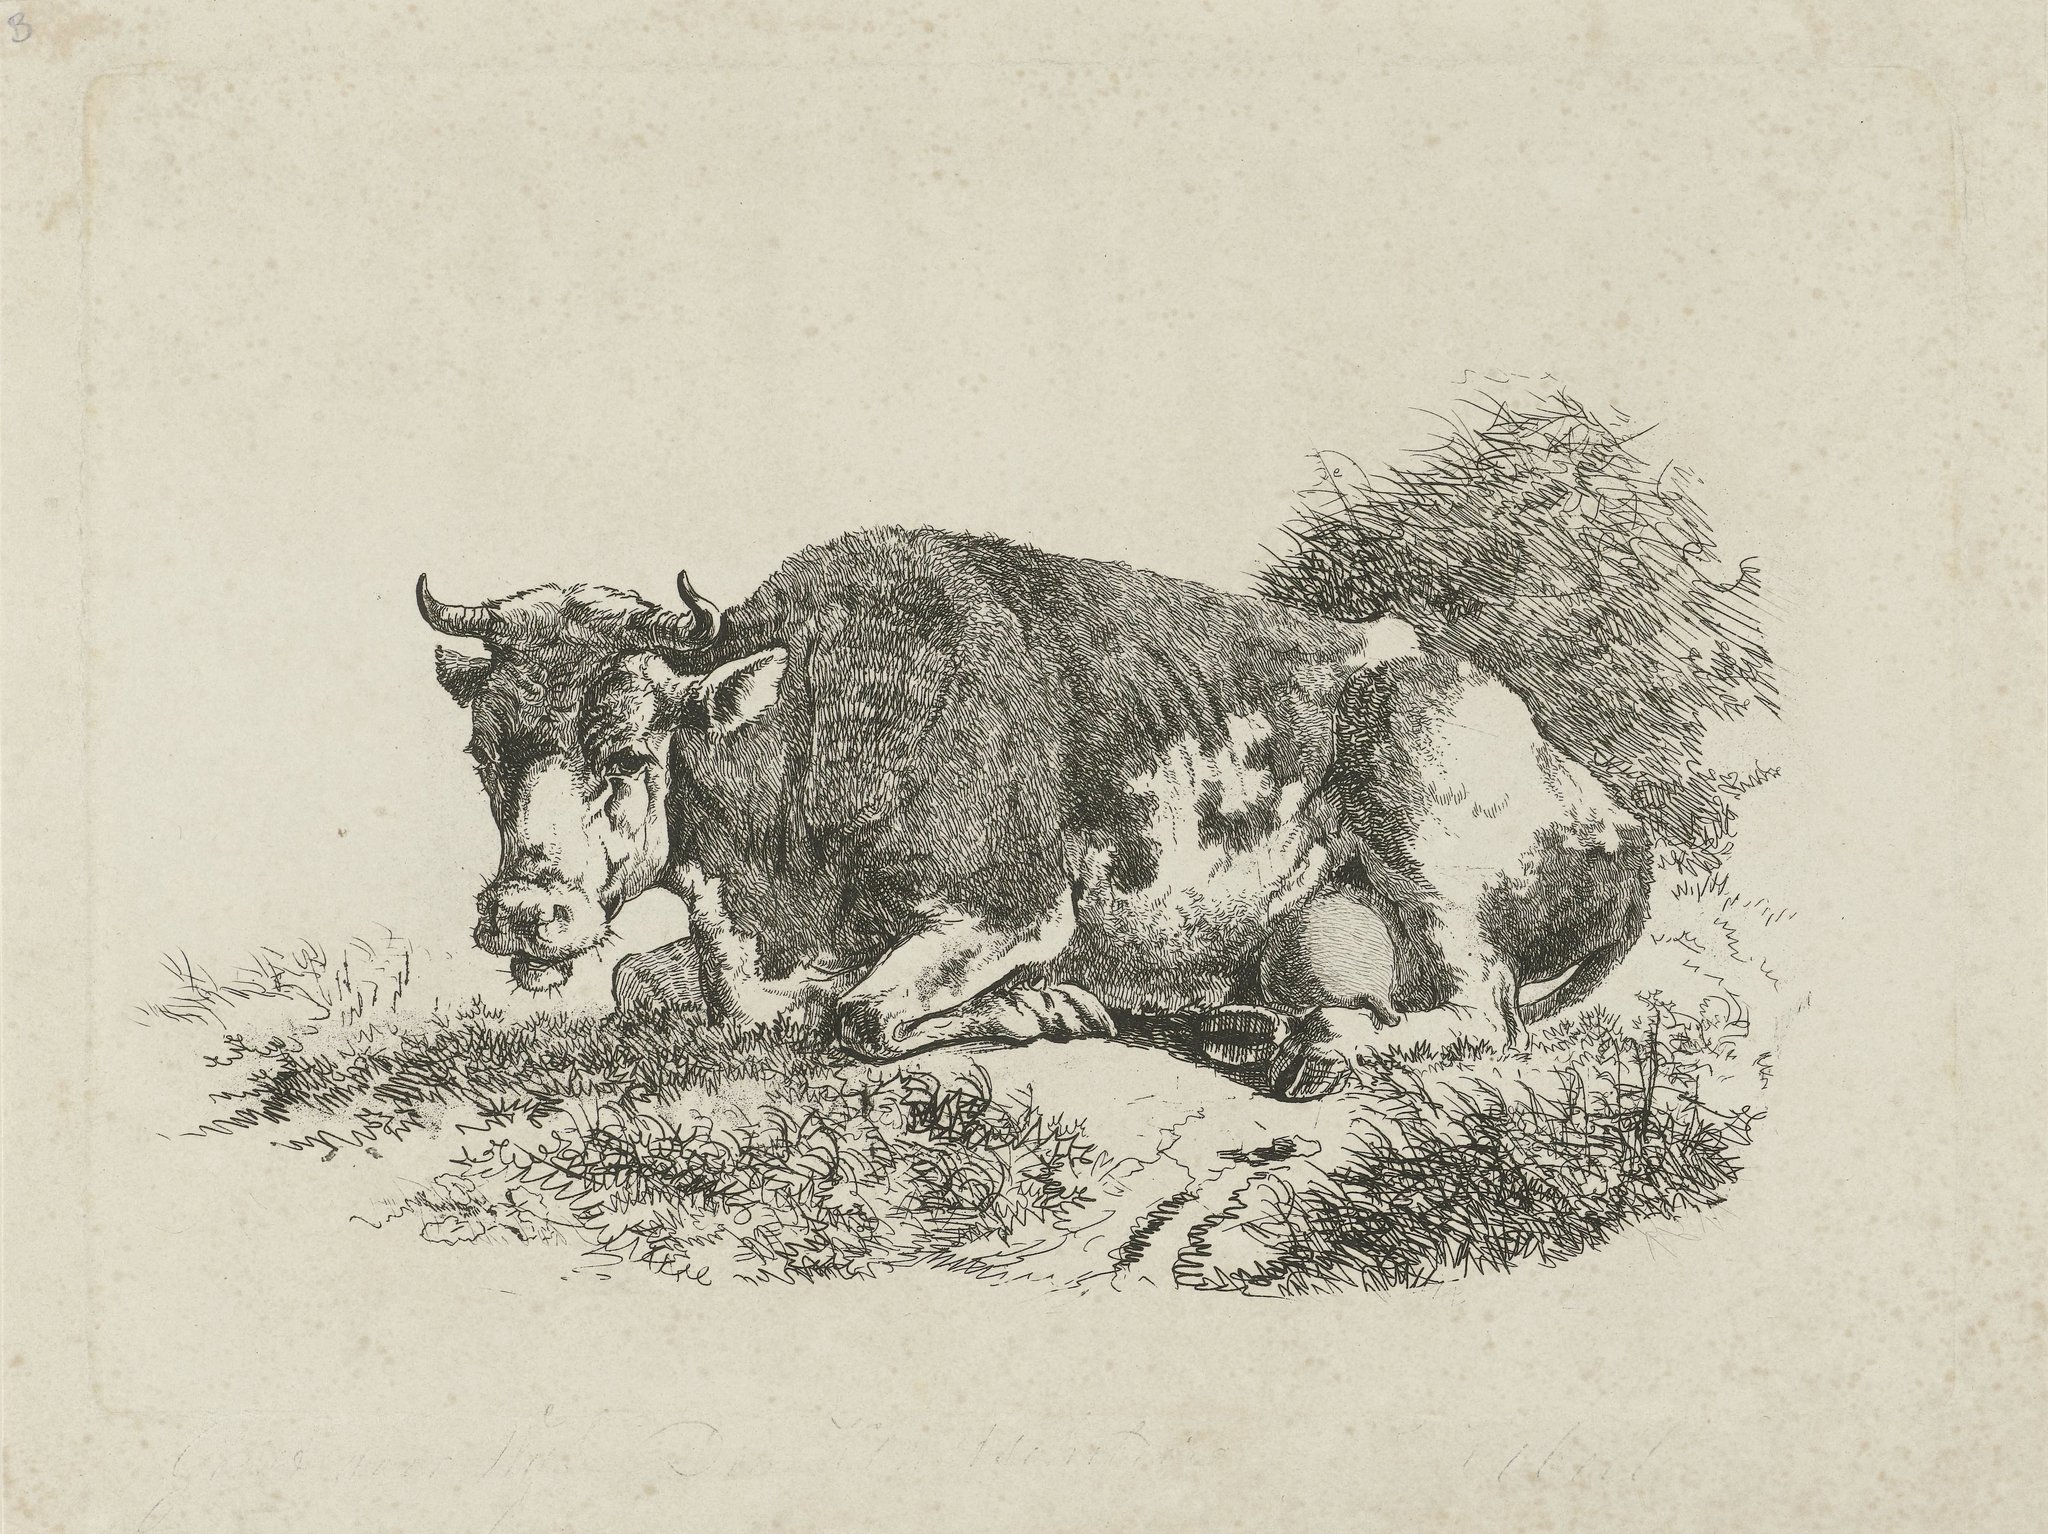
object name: print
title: Liggende koe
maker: jan kobell (iii)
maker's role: painter, print maker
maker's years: 1800-1838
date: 1810-1838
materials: paper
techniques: etching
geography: rotterdam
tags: cow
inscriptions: collector's mark: Lugt 2760, collector's mark: Lugt 2228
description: Liggende koe, naar links, in een landschap. Op de achterzijde van de prent staan twee getekende medaillons.